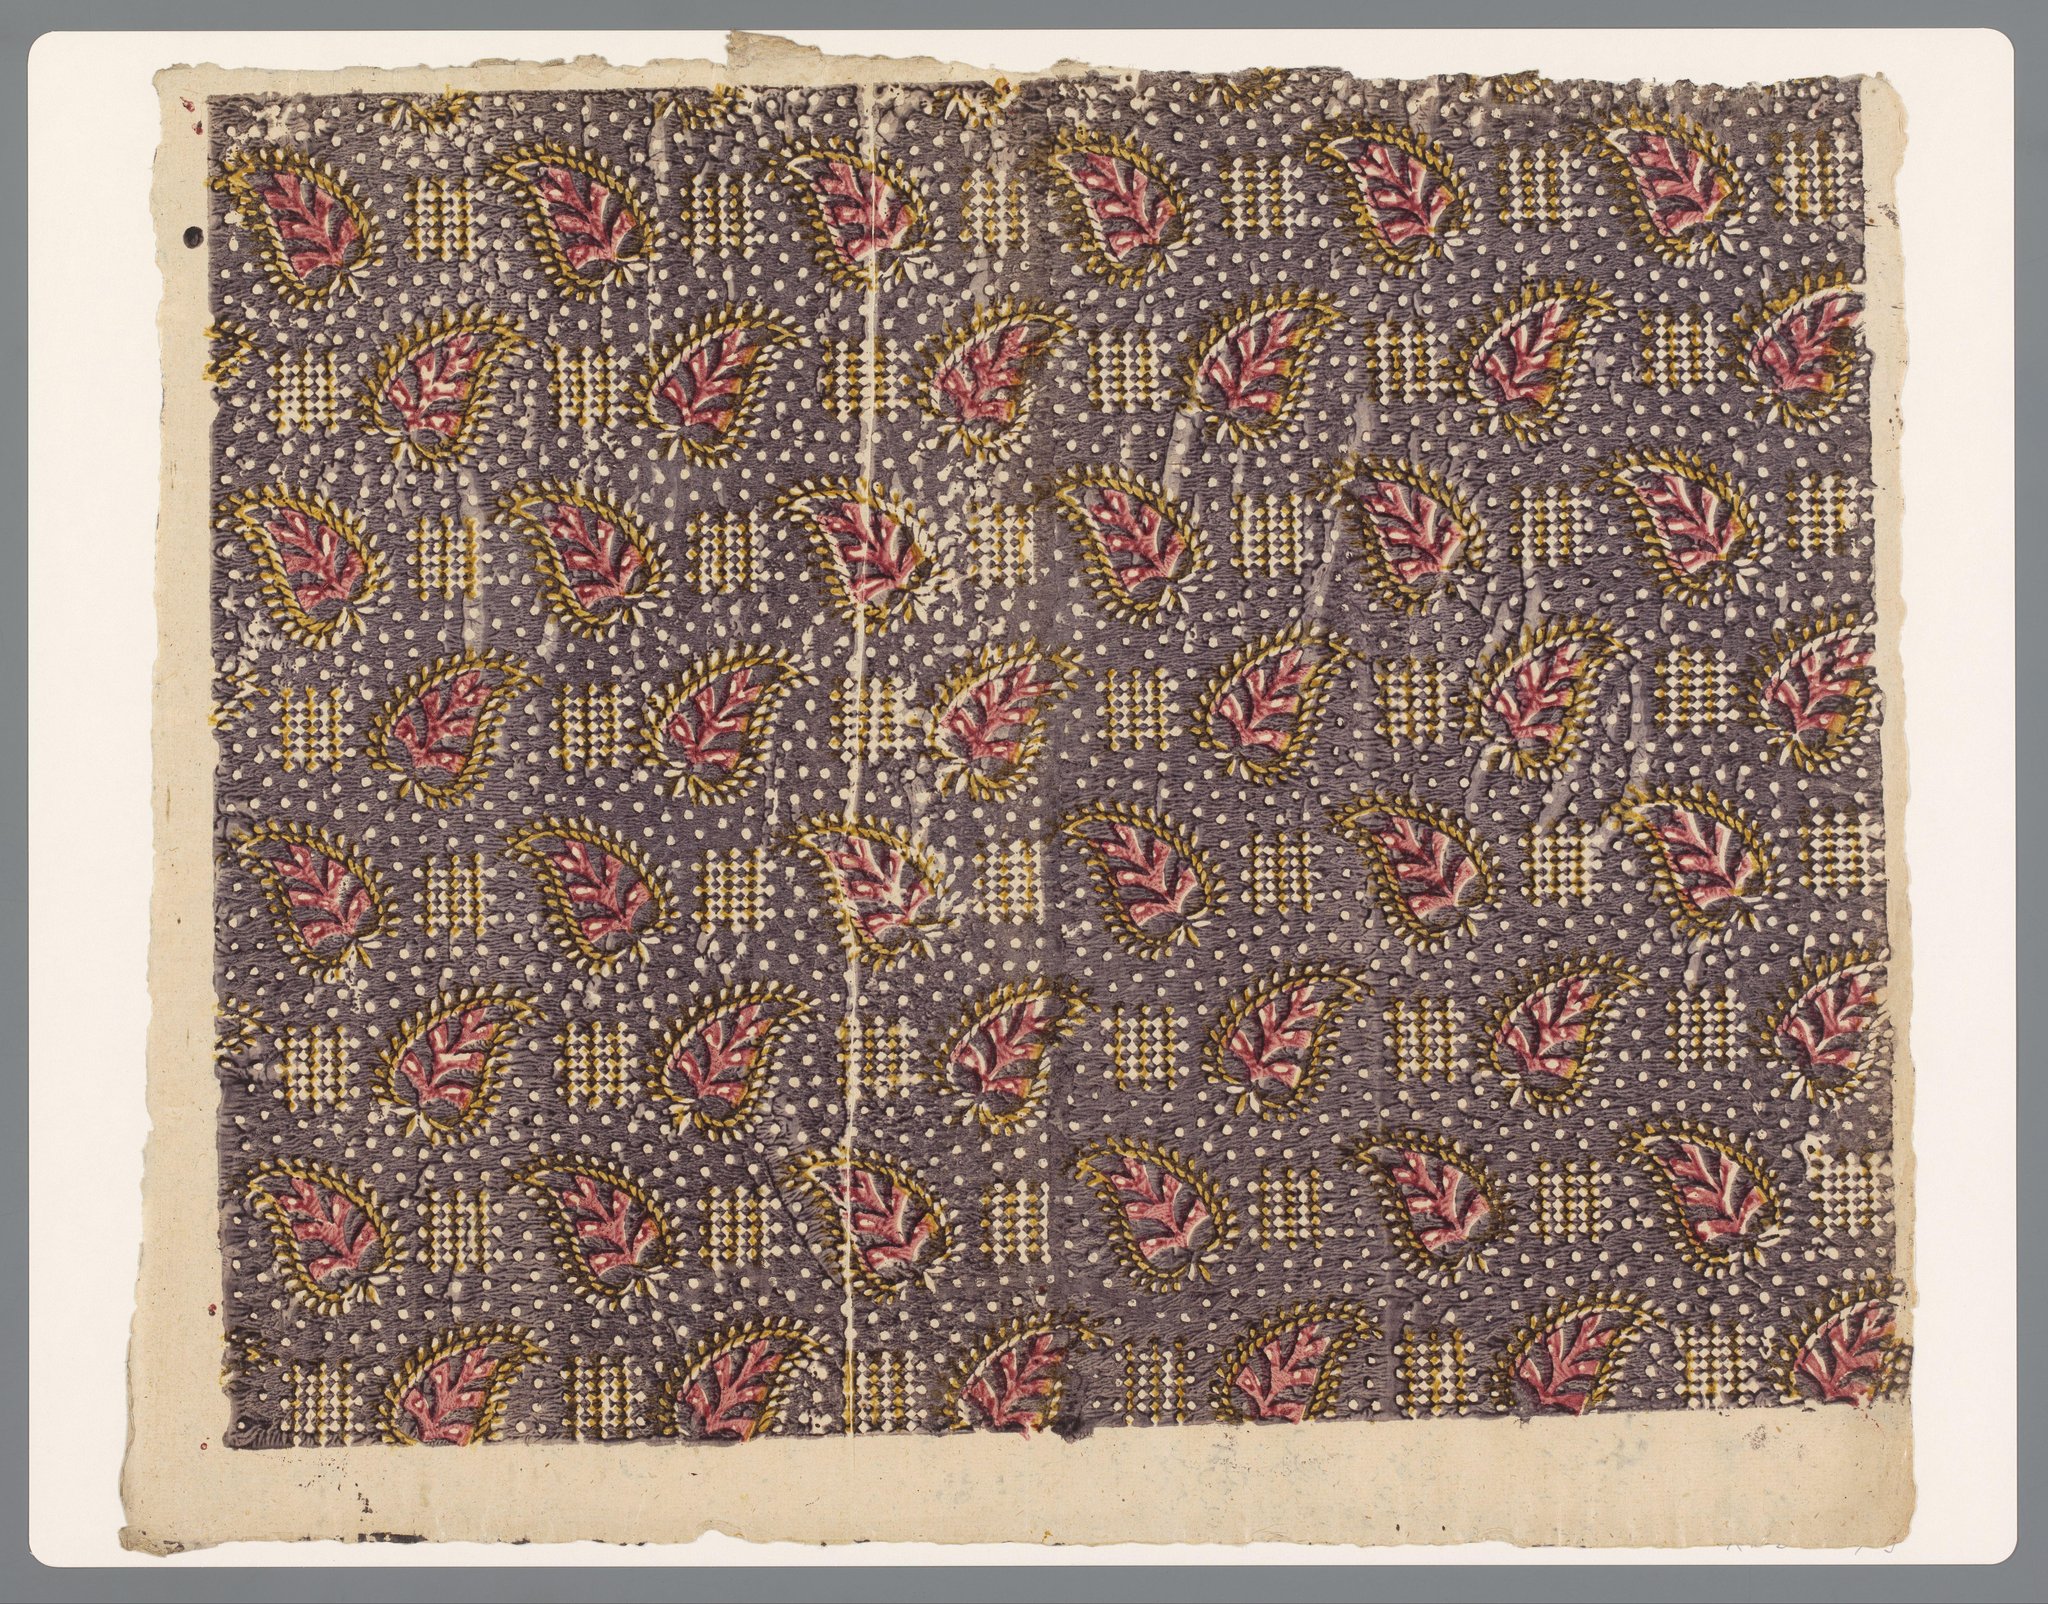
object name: printed paper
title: Blad met alternerend strooipatroon blad- en blokmotief in stippen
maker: Anonymous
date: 1750-1900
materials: lacquer, paper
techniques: printing block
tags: ornament derived from plant forms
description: Blad met alternerend strooipatroon van bladmotief en blokmotief in stippen.